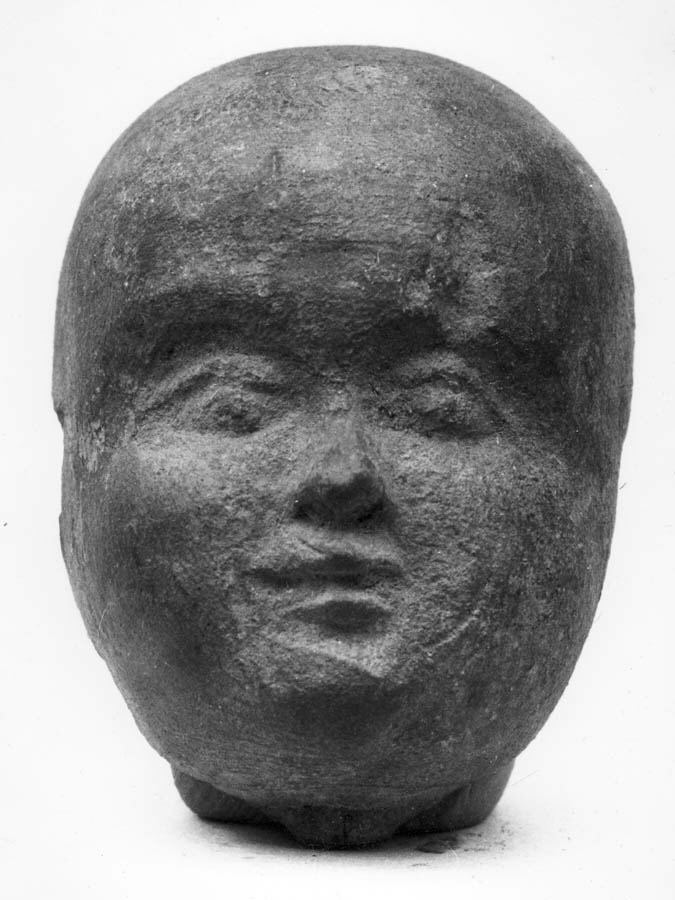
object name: head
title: Male Head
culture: indian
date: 101-300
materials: terracotta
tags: shunga,heads,men